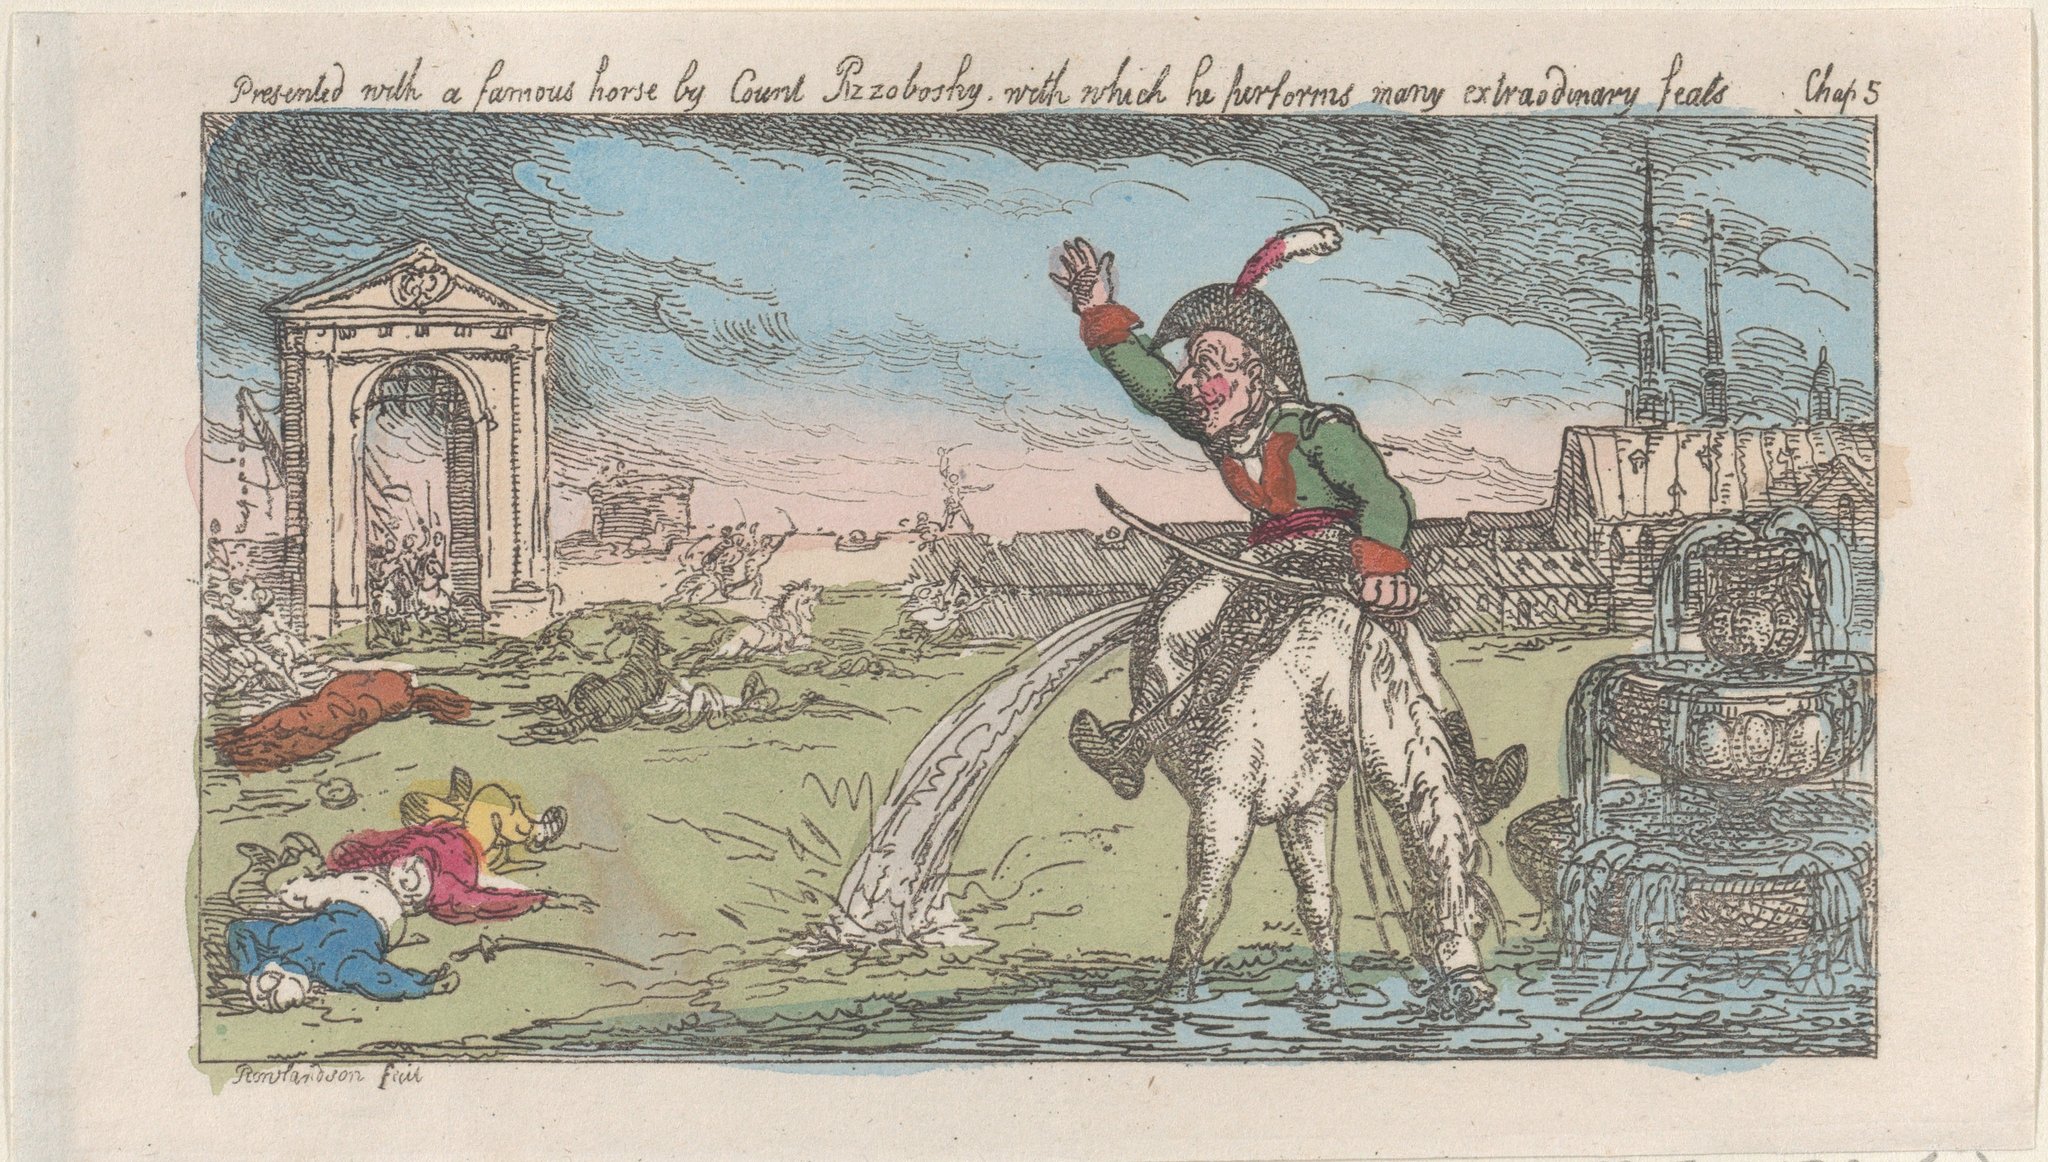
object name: print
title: Presented with a famous horse by Count Przolossky, with which he performs many extraordinary feats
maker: thomas rowlandson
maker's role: artist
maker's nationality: british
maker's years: 1757-1827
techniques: etching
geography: london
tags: satire,fountains,men,horses